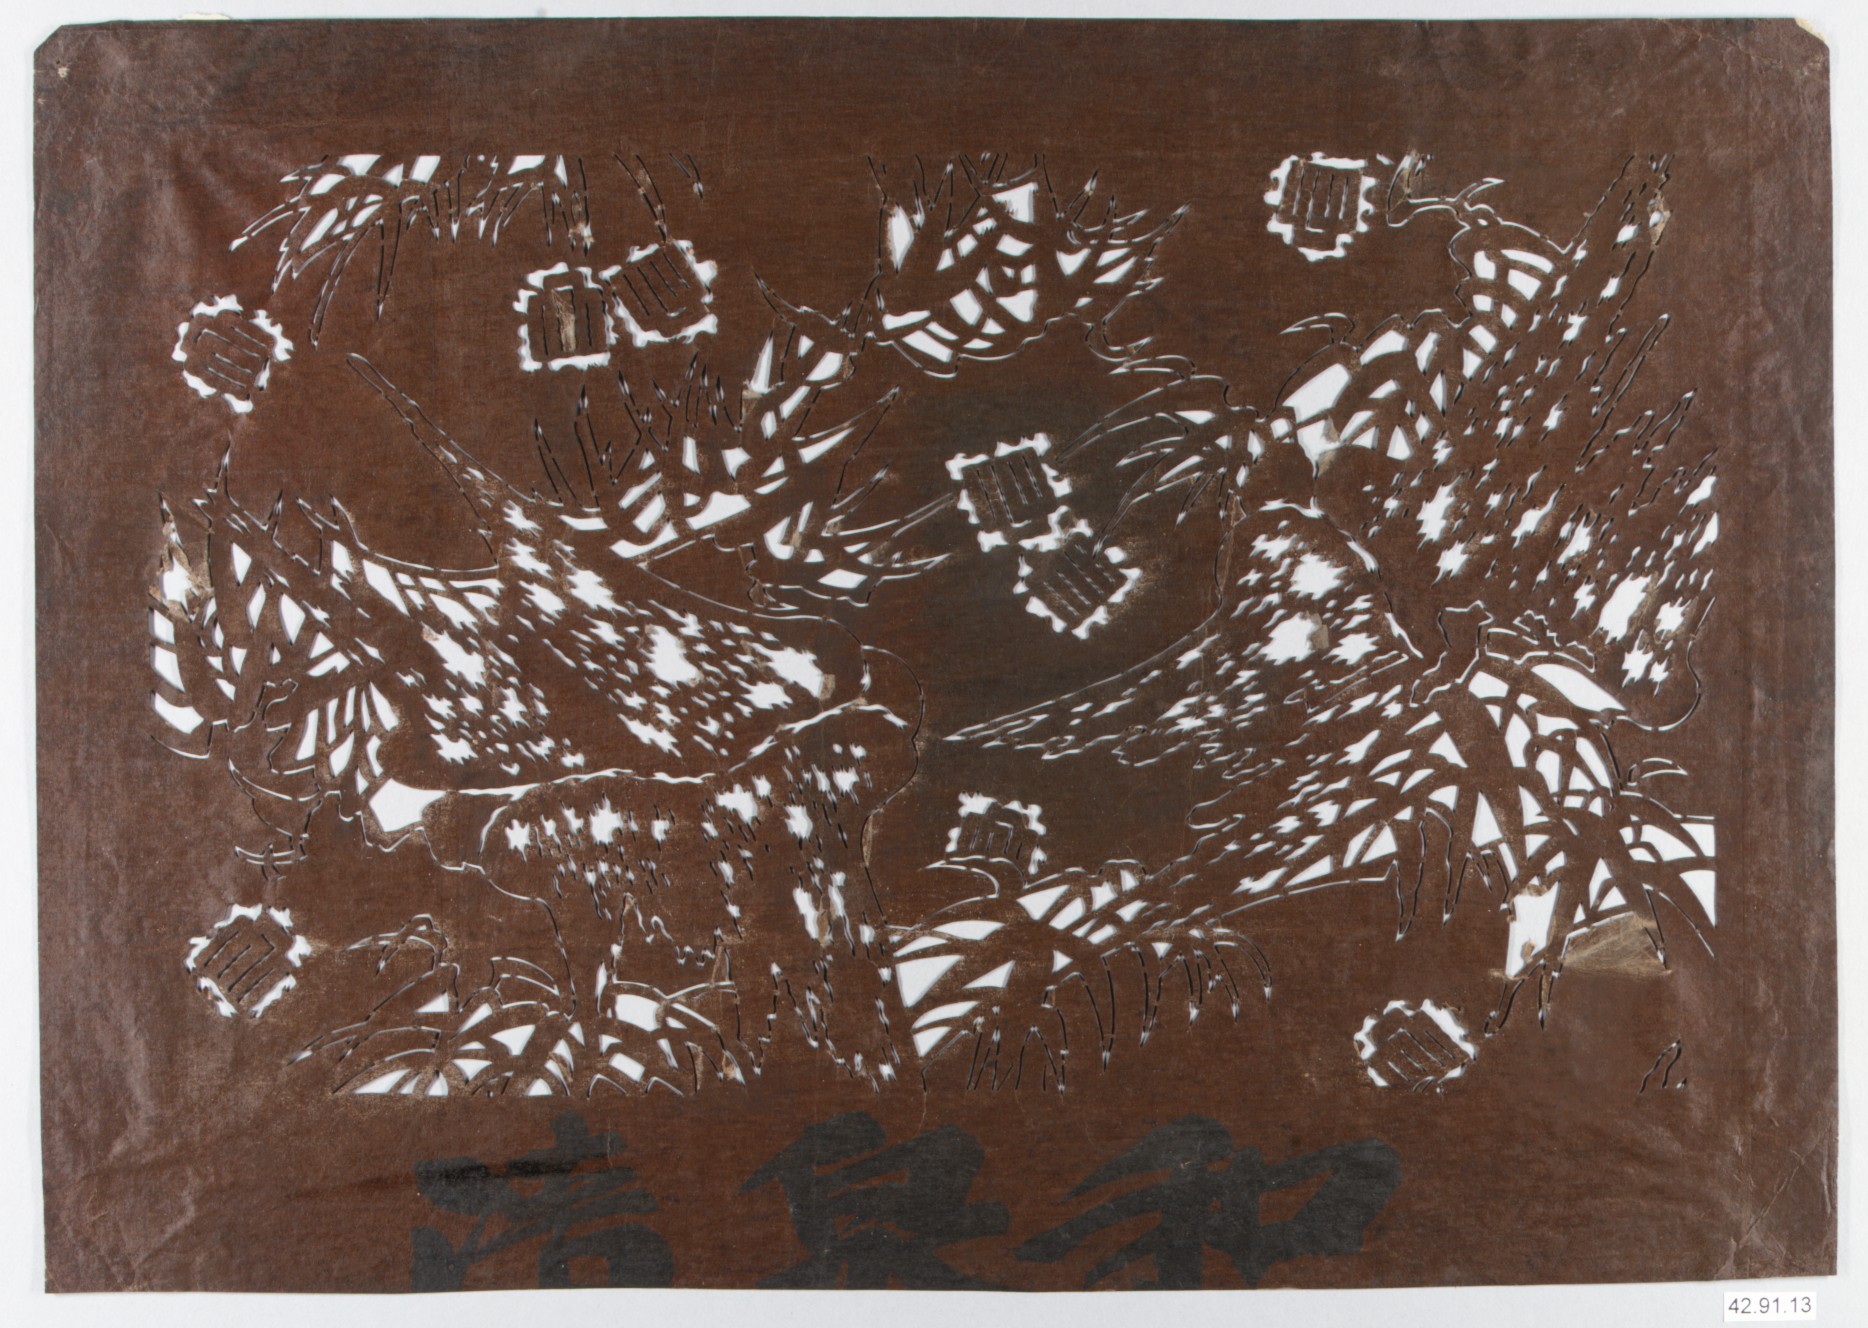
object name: stencil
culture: japanese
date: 1801-1900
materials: paper